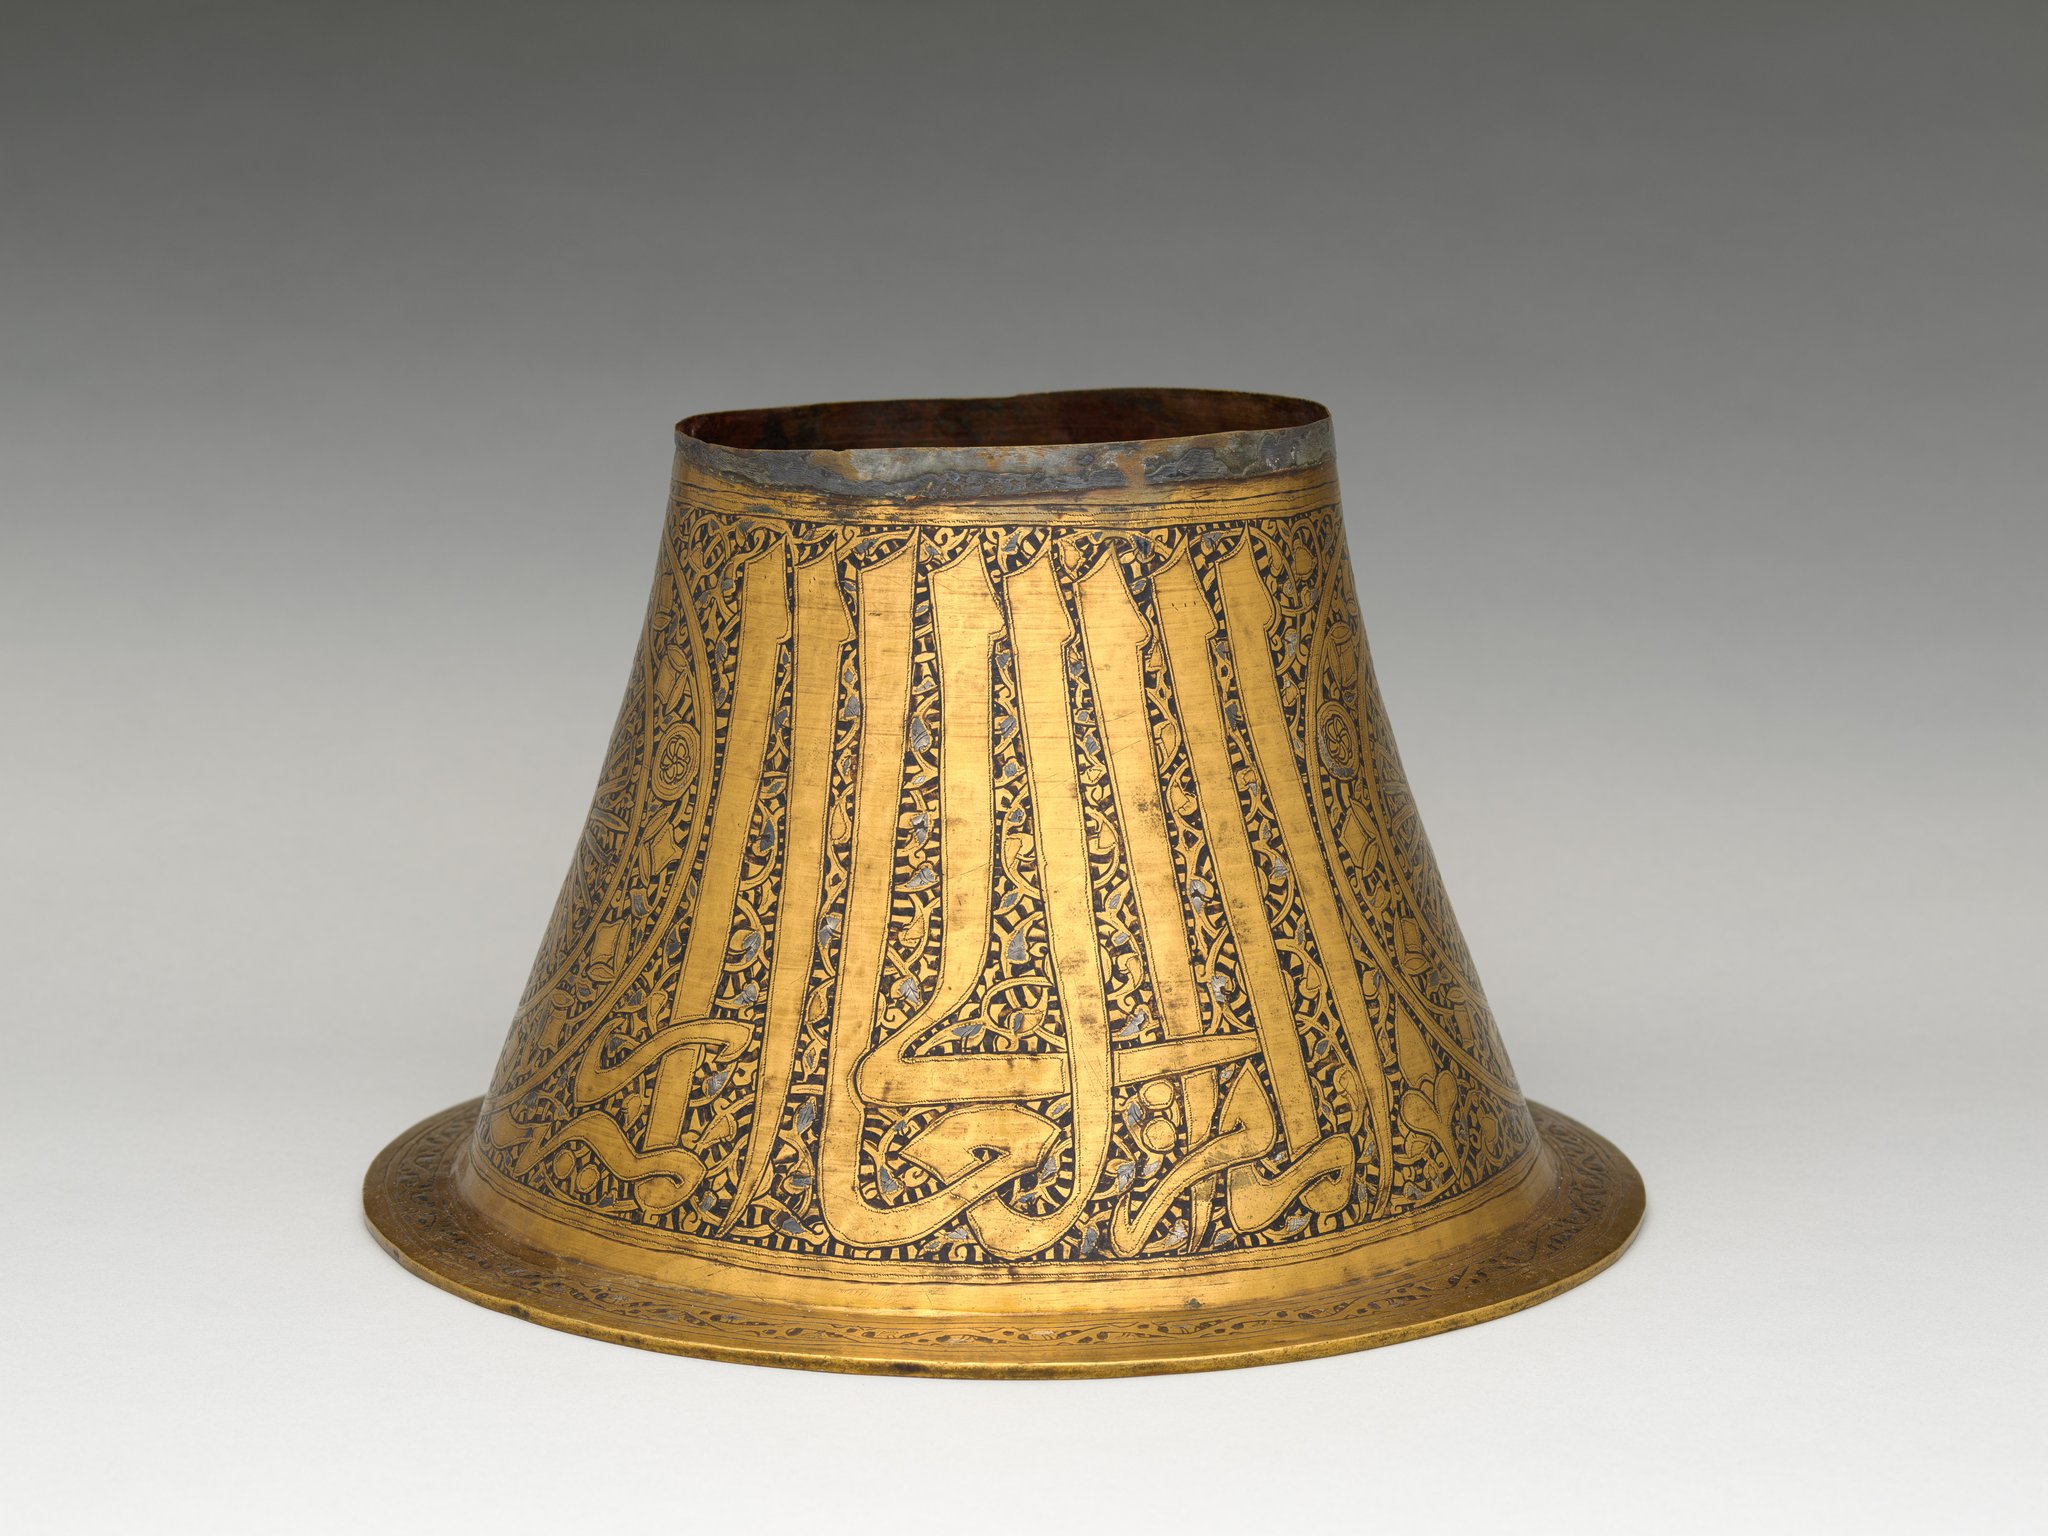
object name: candlestick base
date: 1351-1400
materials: brass, silver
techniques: engraving, inlay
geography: egypt or syria